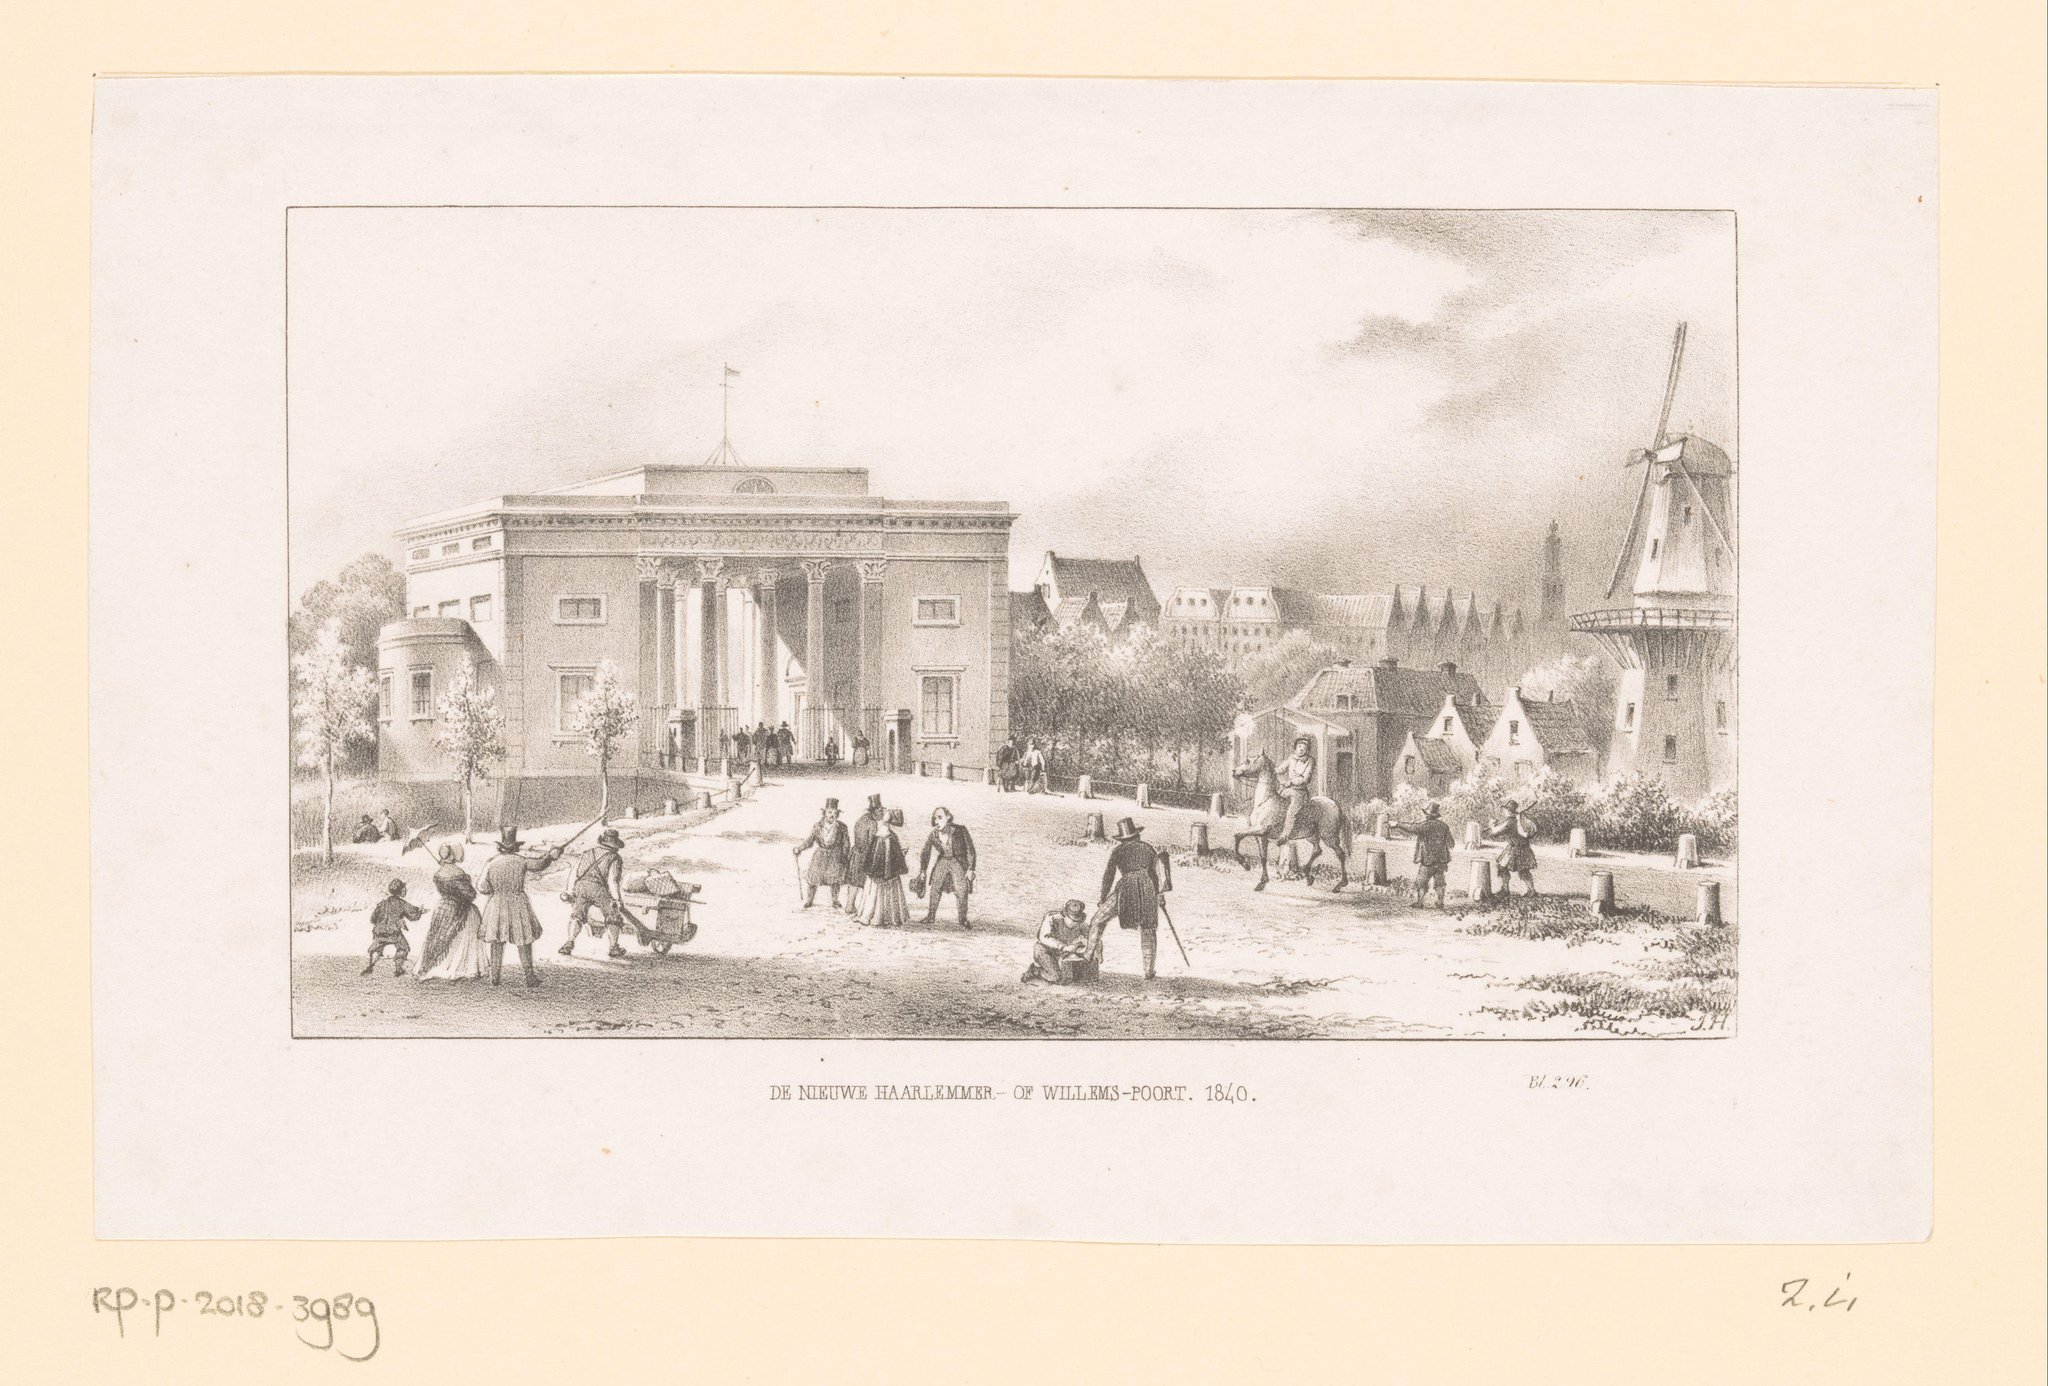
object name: print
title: De nieuwe Haarlemmer- of Willem-poort 1840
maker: Anonymous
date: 1800-1899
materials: paper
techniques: lithograph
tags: care of clothes, e.g.: brushing, beating, airing, windmill in landscape, city-gate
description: Rechts onderin de steen gemonogrammeerd "I.H." of "J.H.".